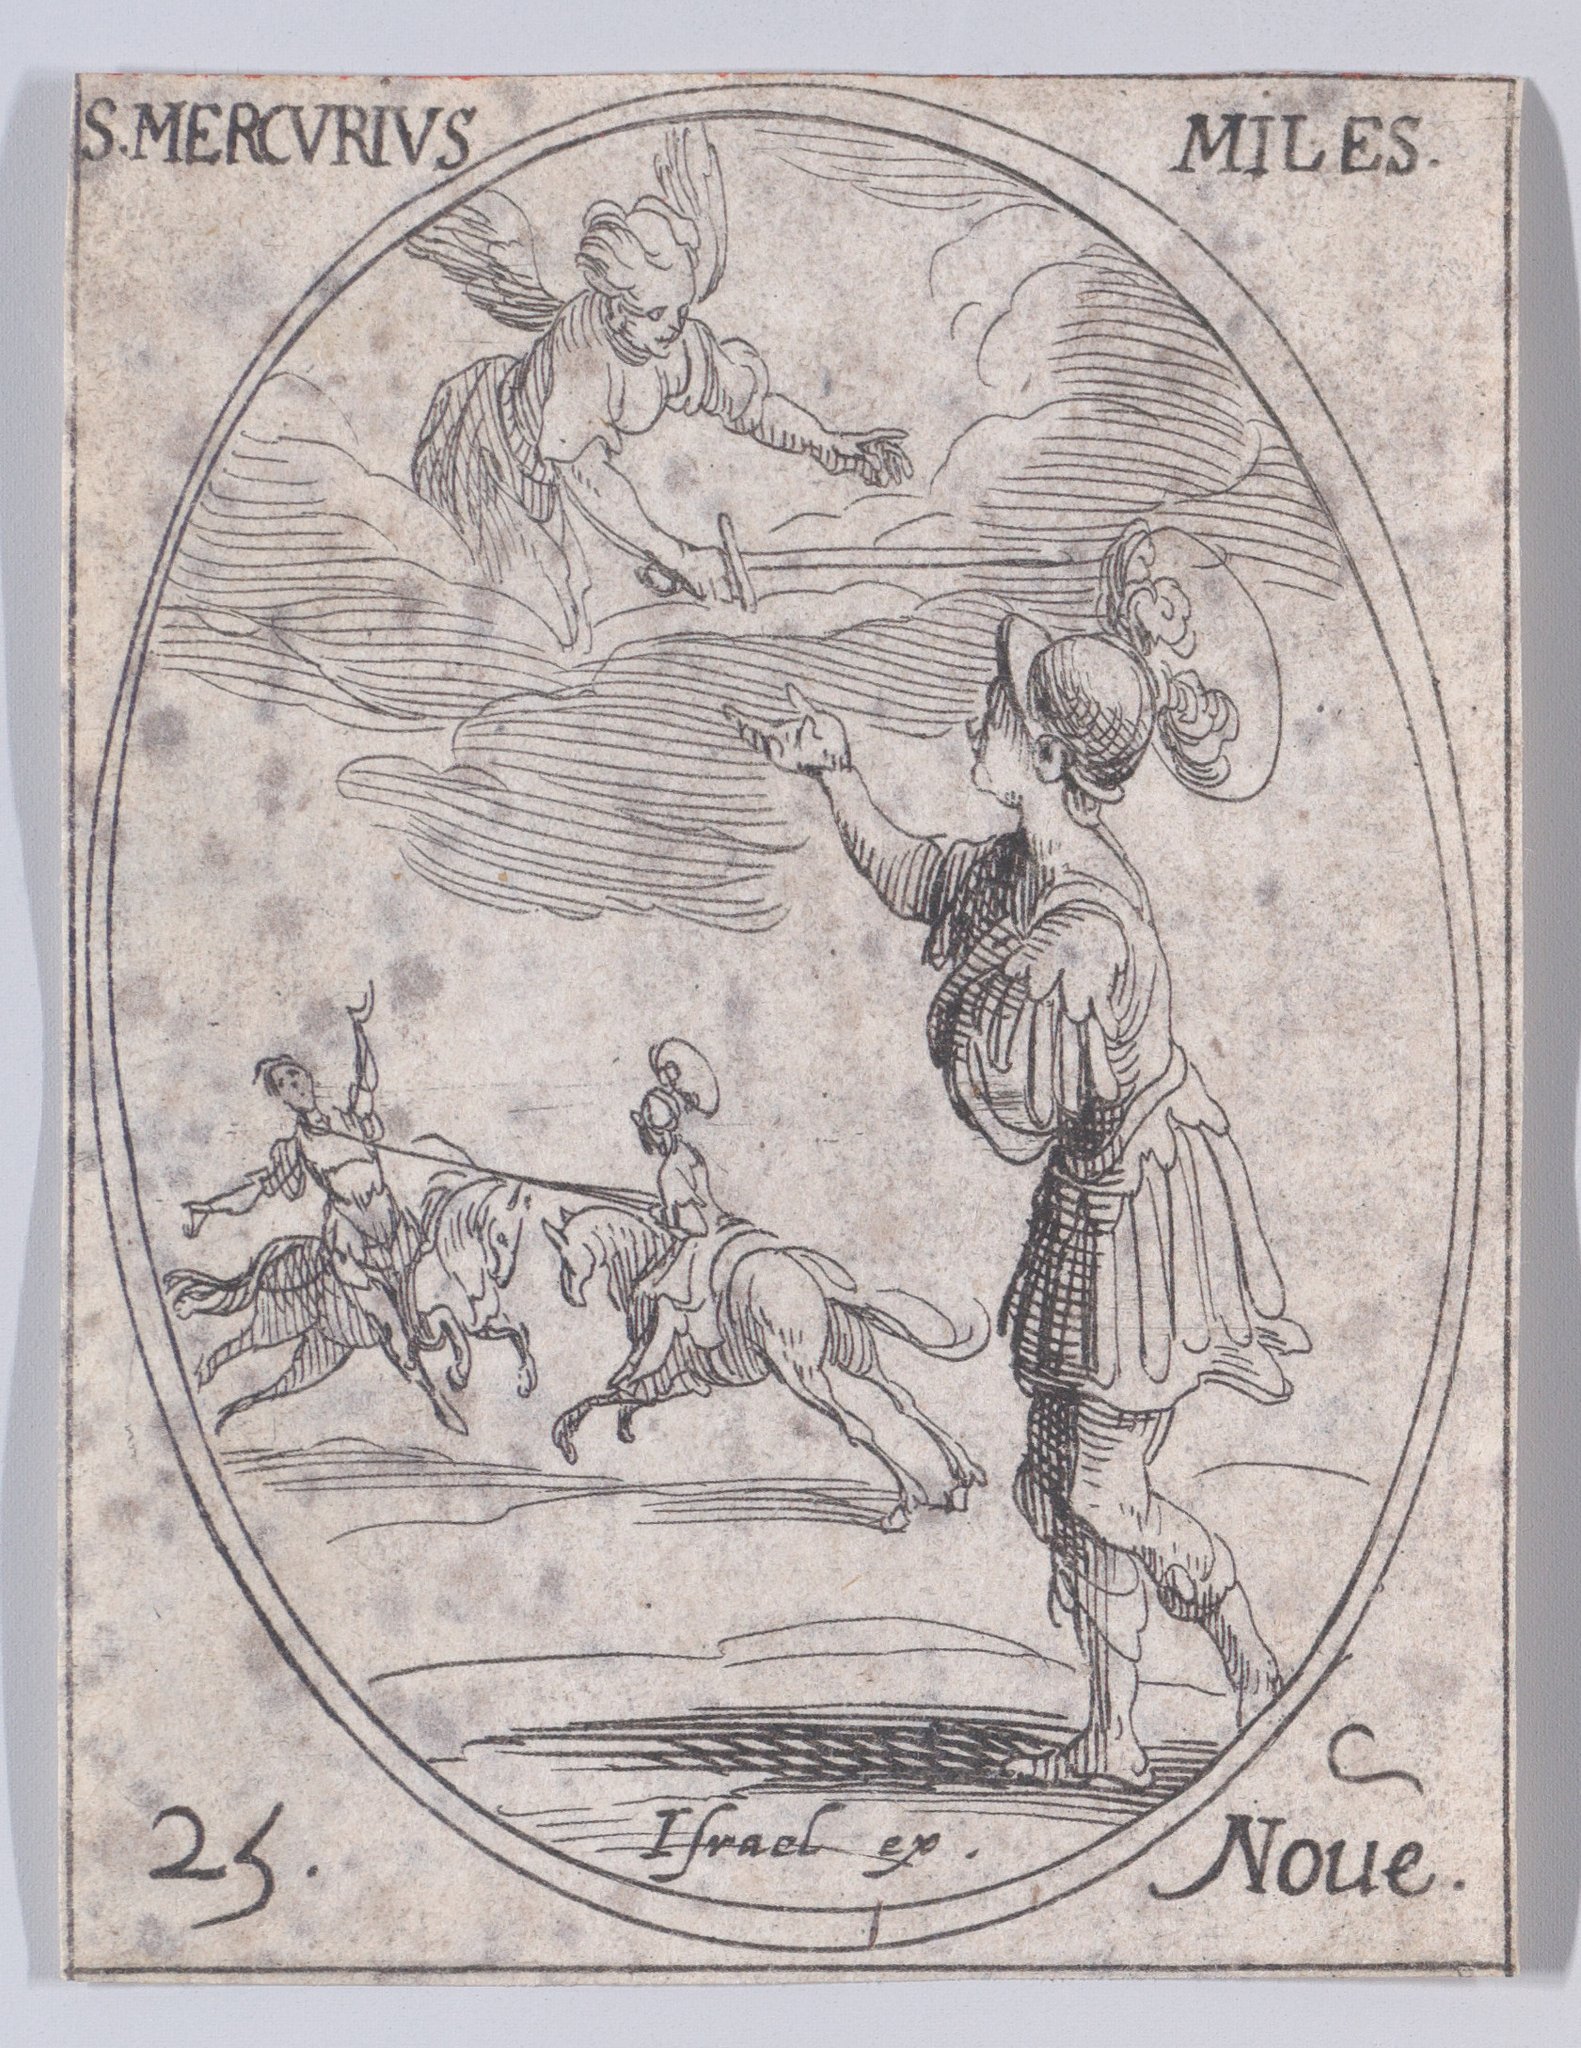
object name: print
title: S. Mercure, soldat (St. Mercury, Soldier), November 25th, from "Les Images De Tous Les Saincts et Saintes de L'Année" (Images of All of the Saints and Religious Events of the Year)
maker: jacques callot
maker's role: artist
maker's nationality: french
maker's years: 1592-1635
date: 1636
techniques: etching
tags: men,saints